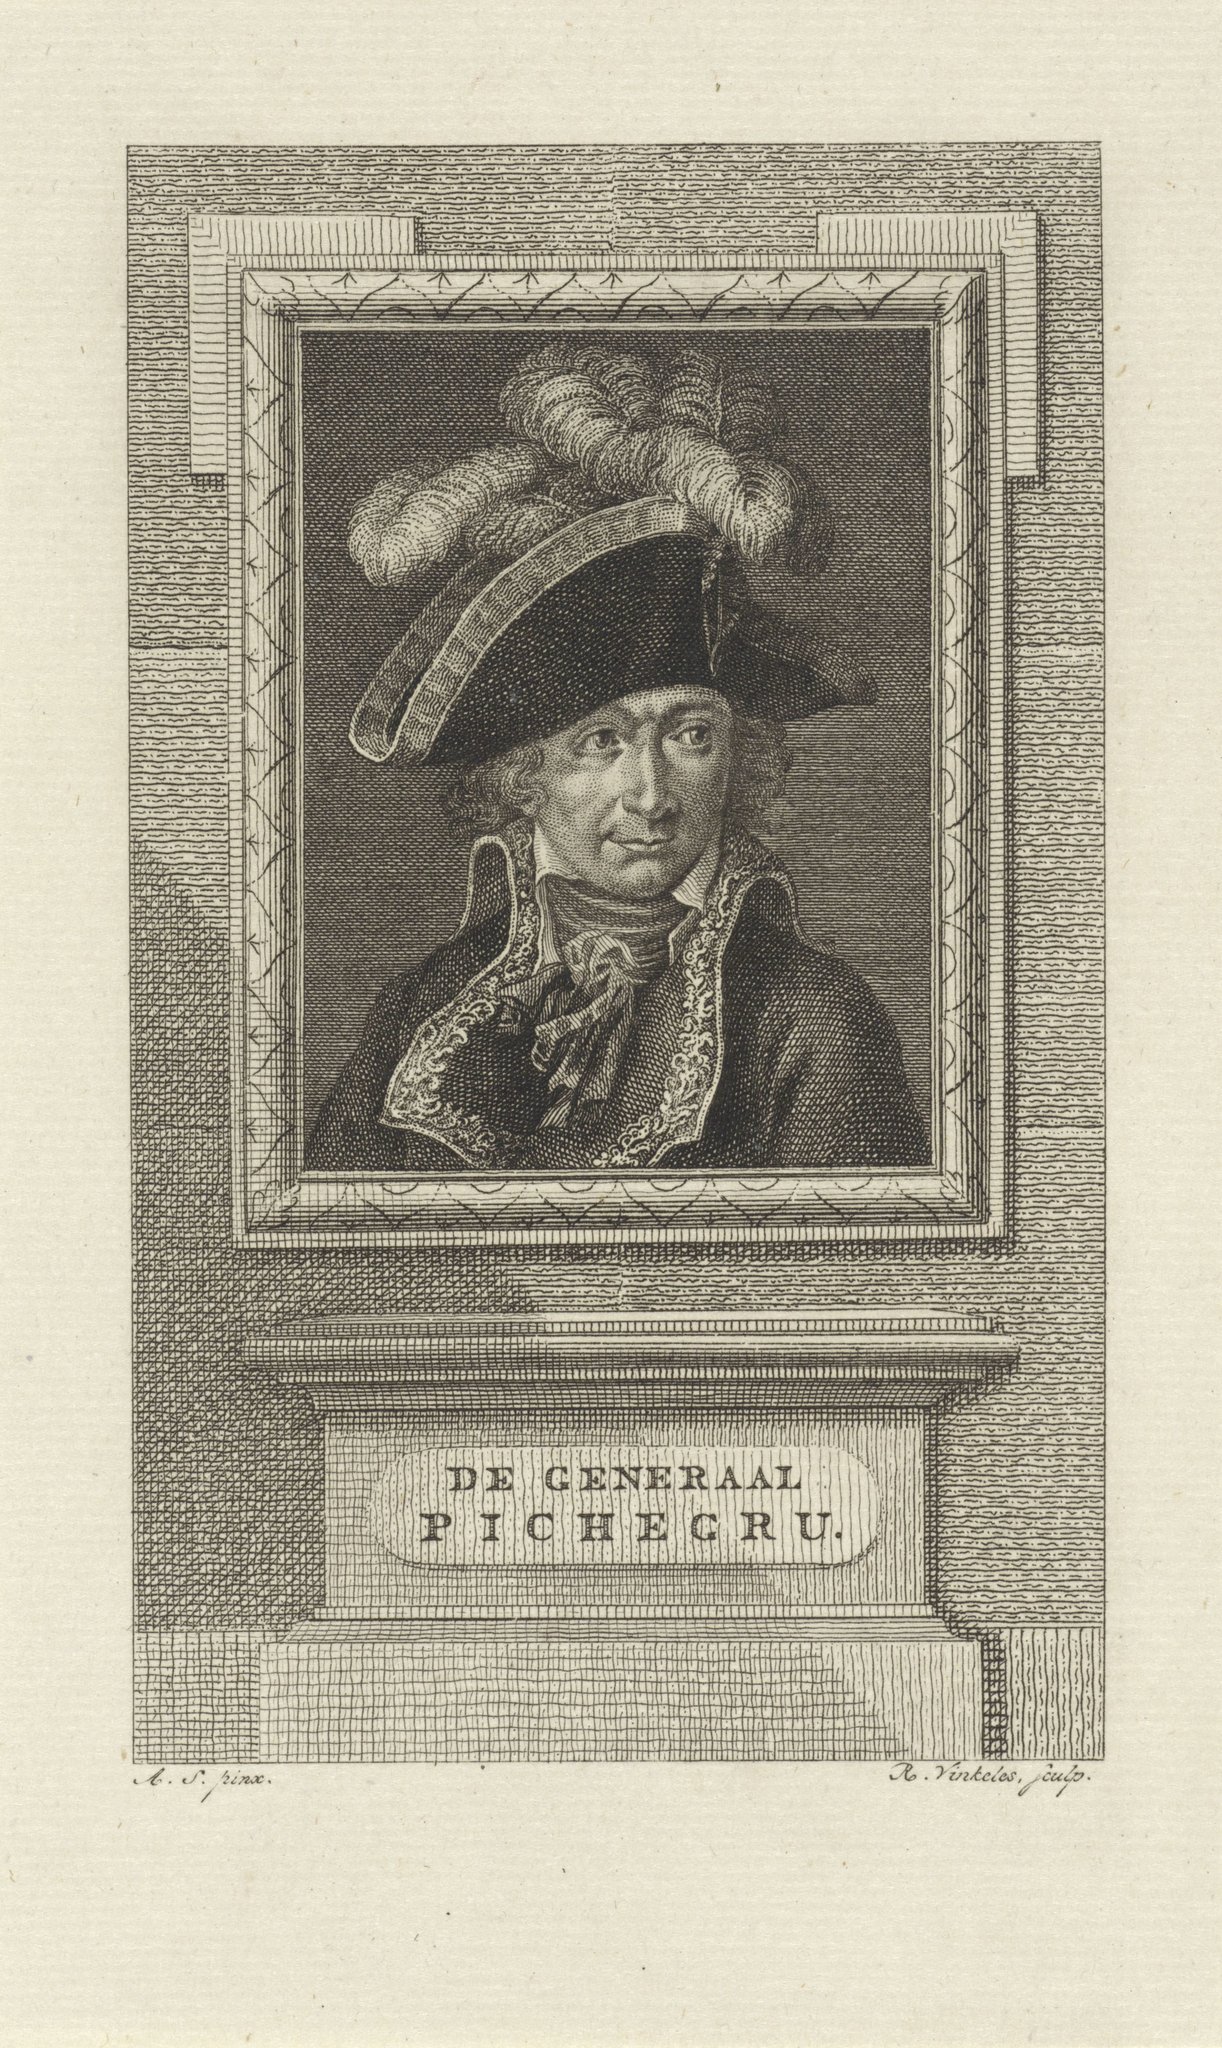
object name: print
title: Portret van Jean-Charles Pichegru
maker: reinier vinkeles (i)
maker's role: draughtsman, print maker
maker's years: 1741-1816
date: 1786-1809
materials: paper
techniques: engraving, etching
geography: amsterdam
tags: paris, politician, jean-charles pichegru, historical persons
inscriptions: collector's mark: Lugt 2228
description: Prent ook gebruikt als boekillustratie in: Wagenaar, Jan. Vaderlandsche historie, (...) ten vervolge van Wagenaars Vaderlandsche historie. Dl. 1-43. Amsterdam: Johannes Allart, 1786-1809.